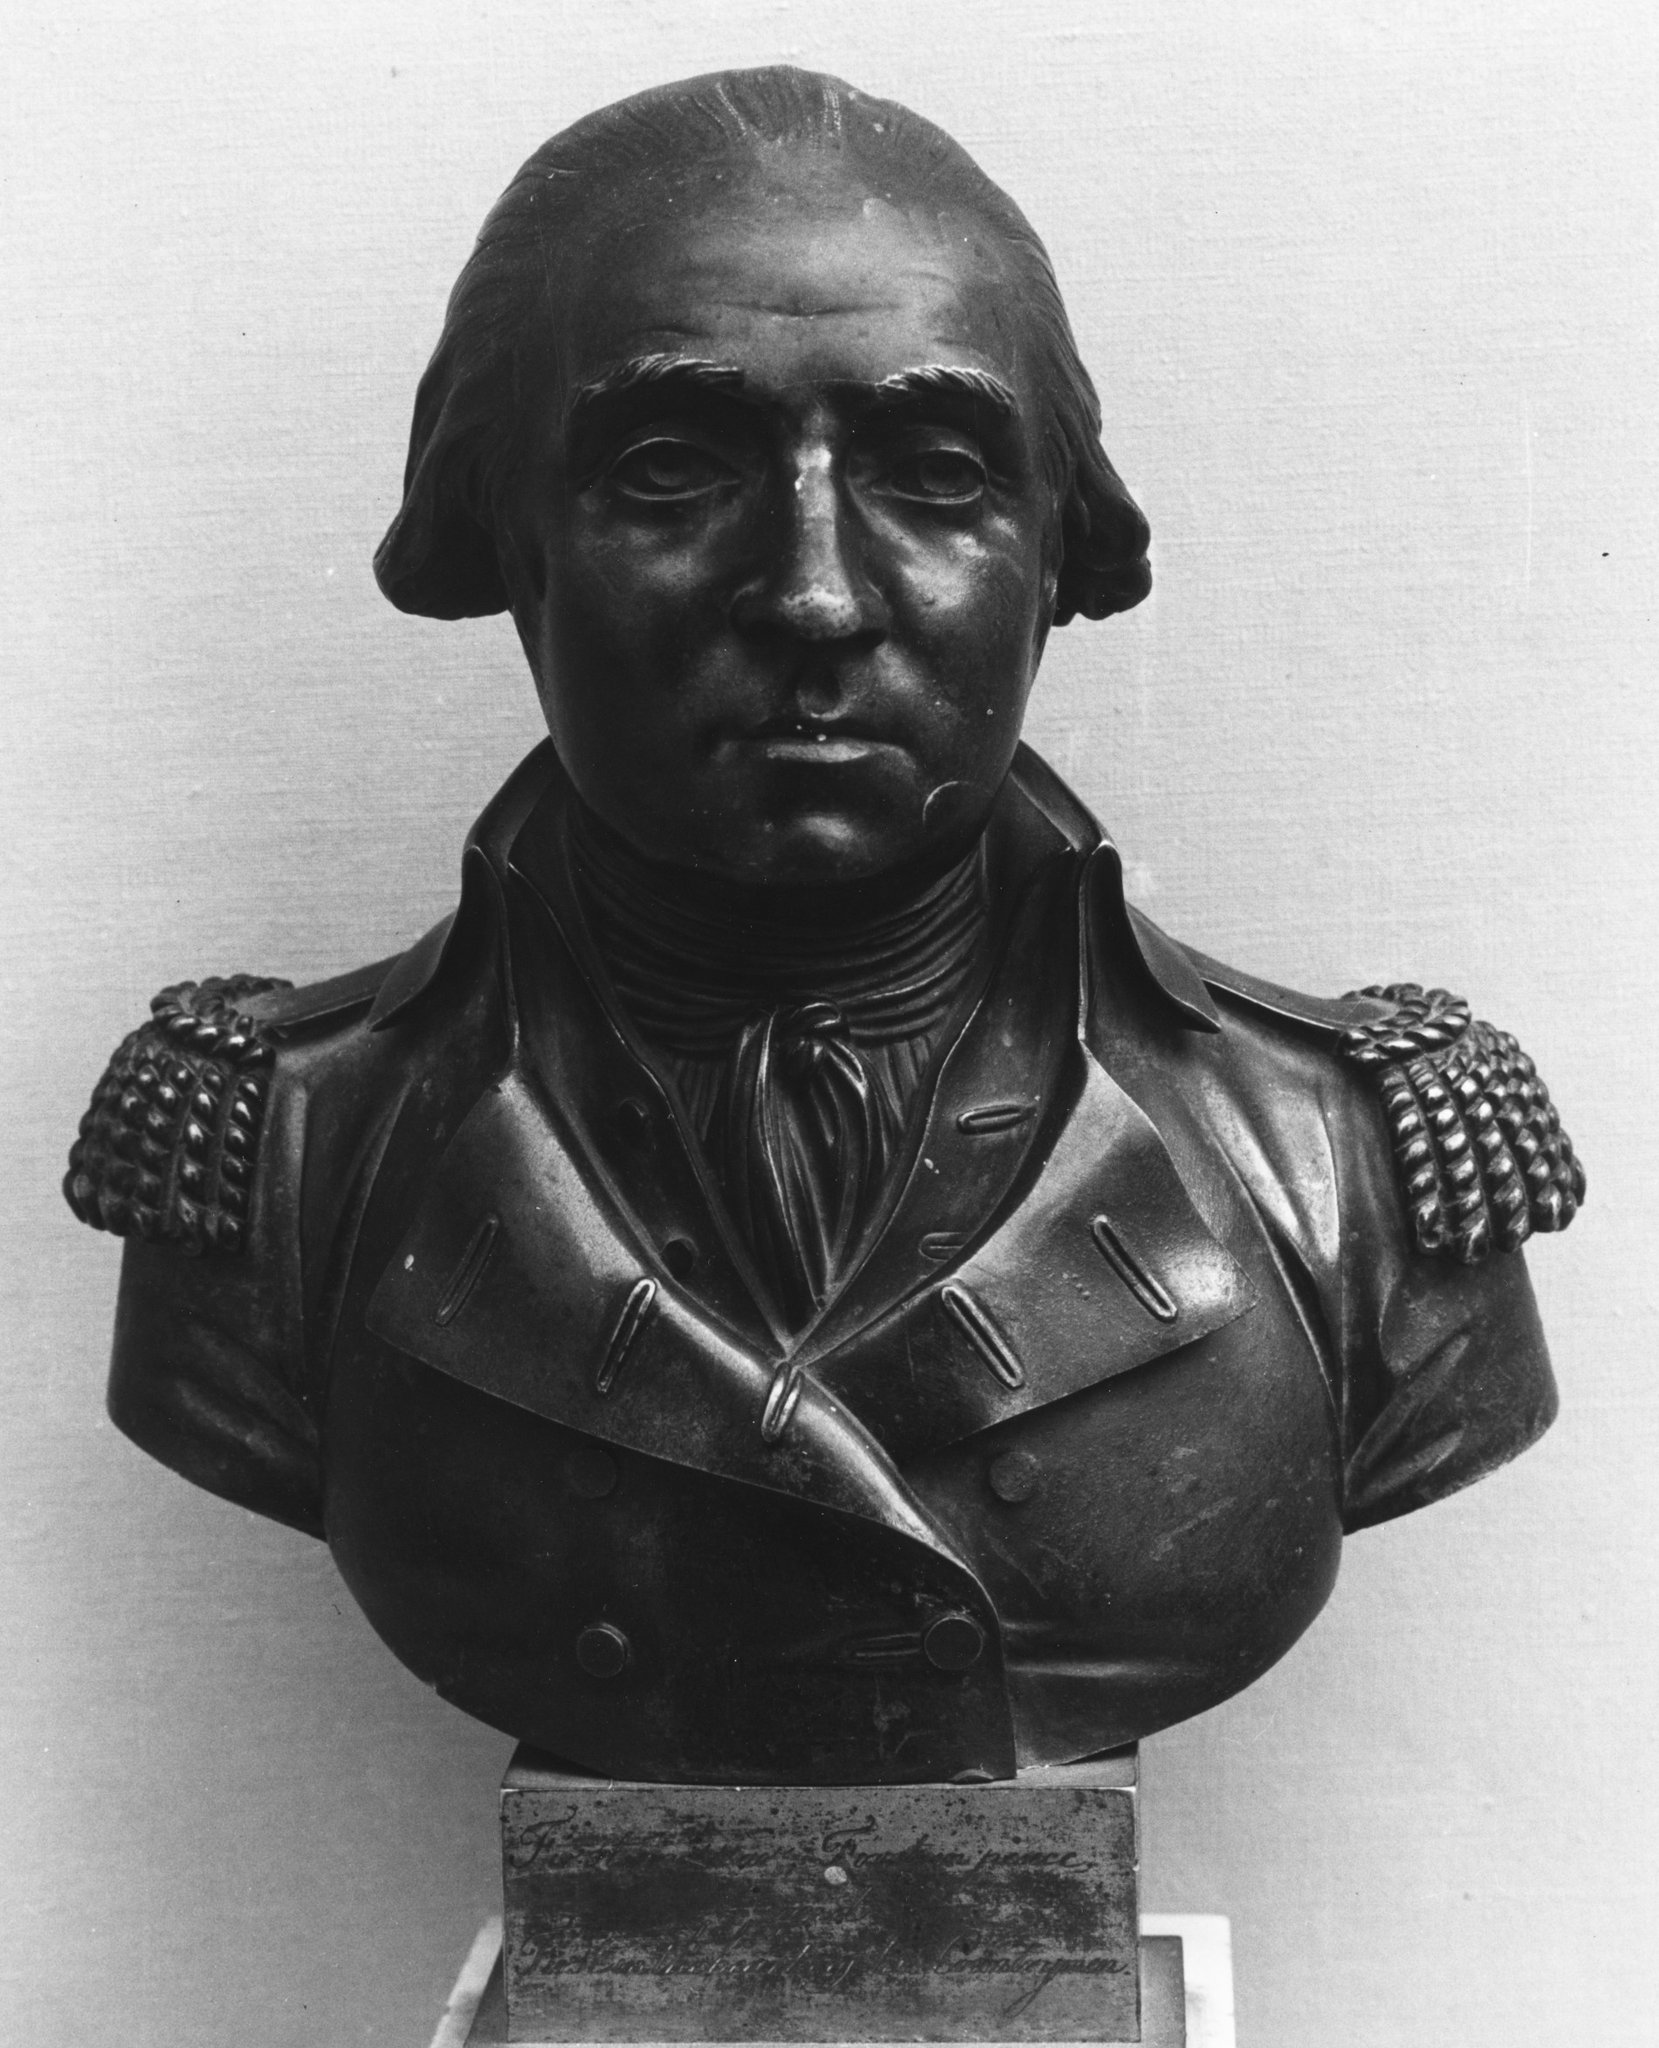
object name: bust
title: Bust of George Washington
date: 1800-1830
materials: bronze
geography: france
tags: george washington,portraits